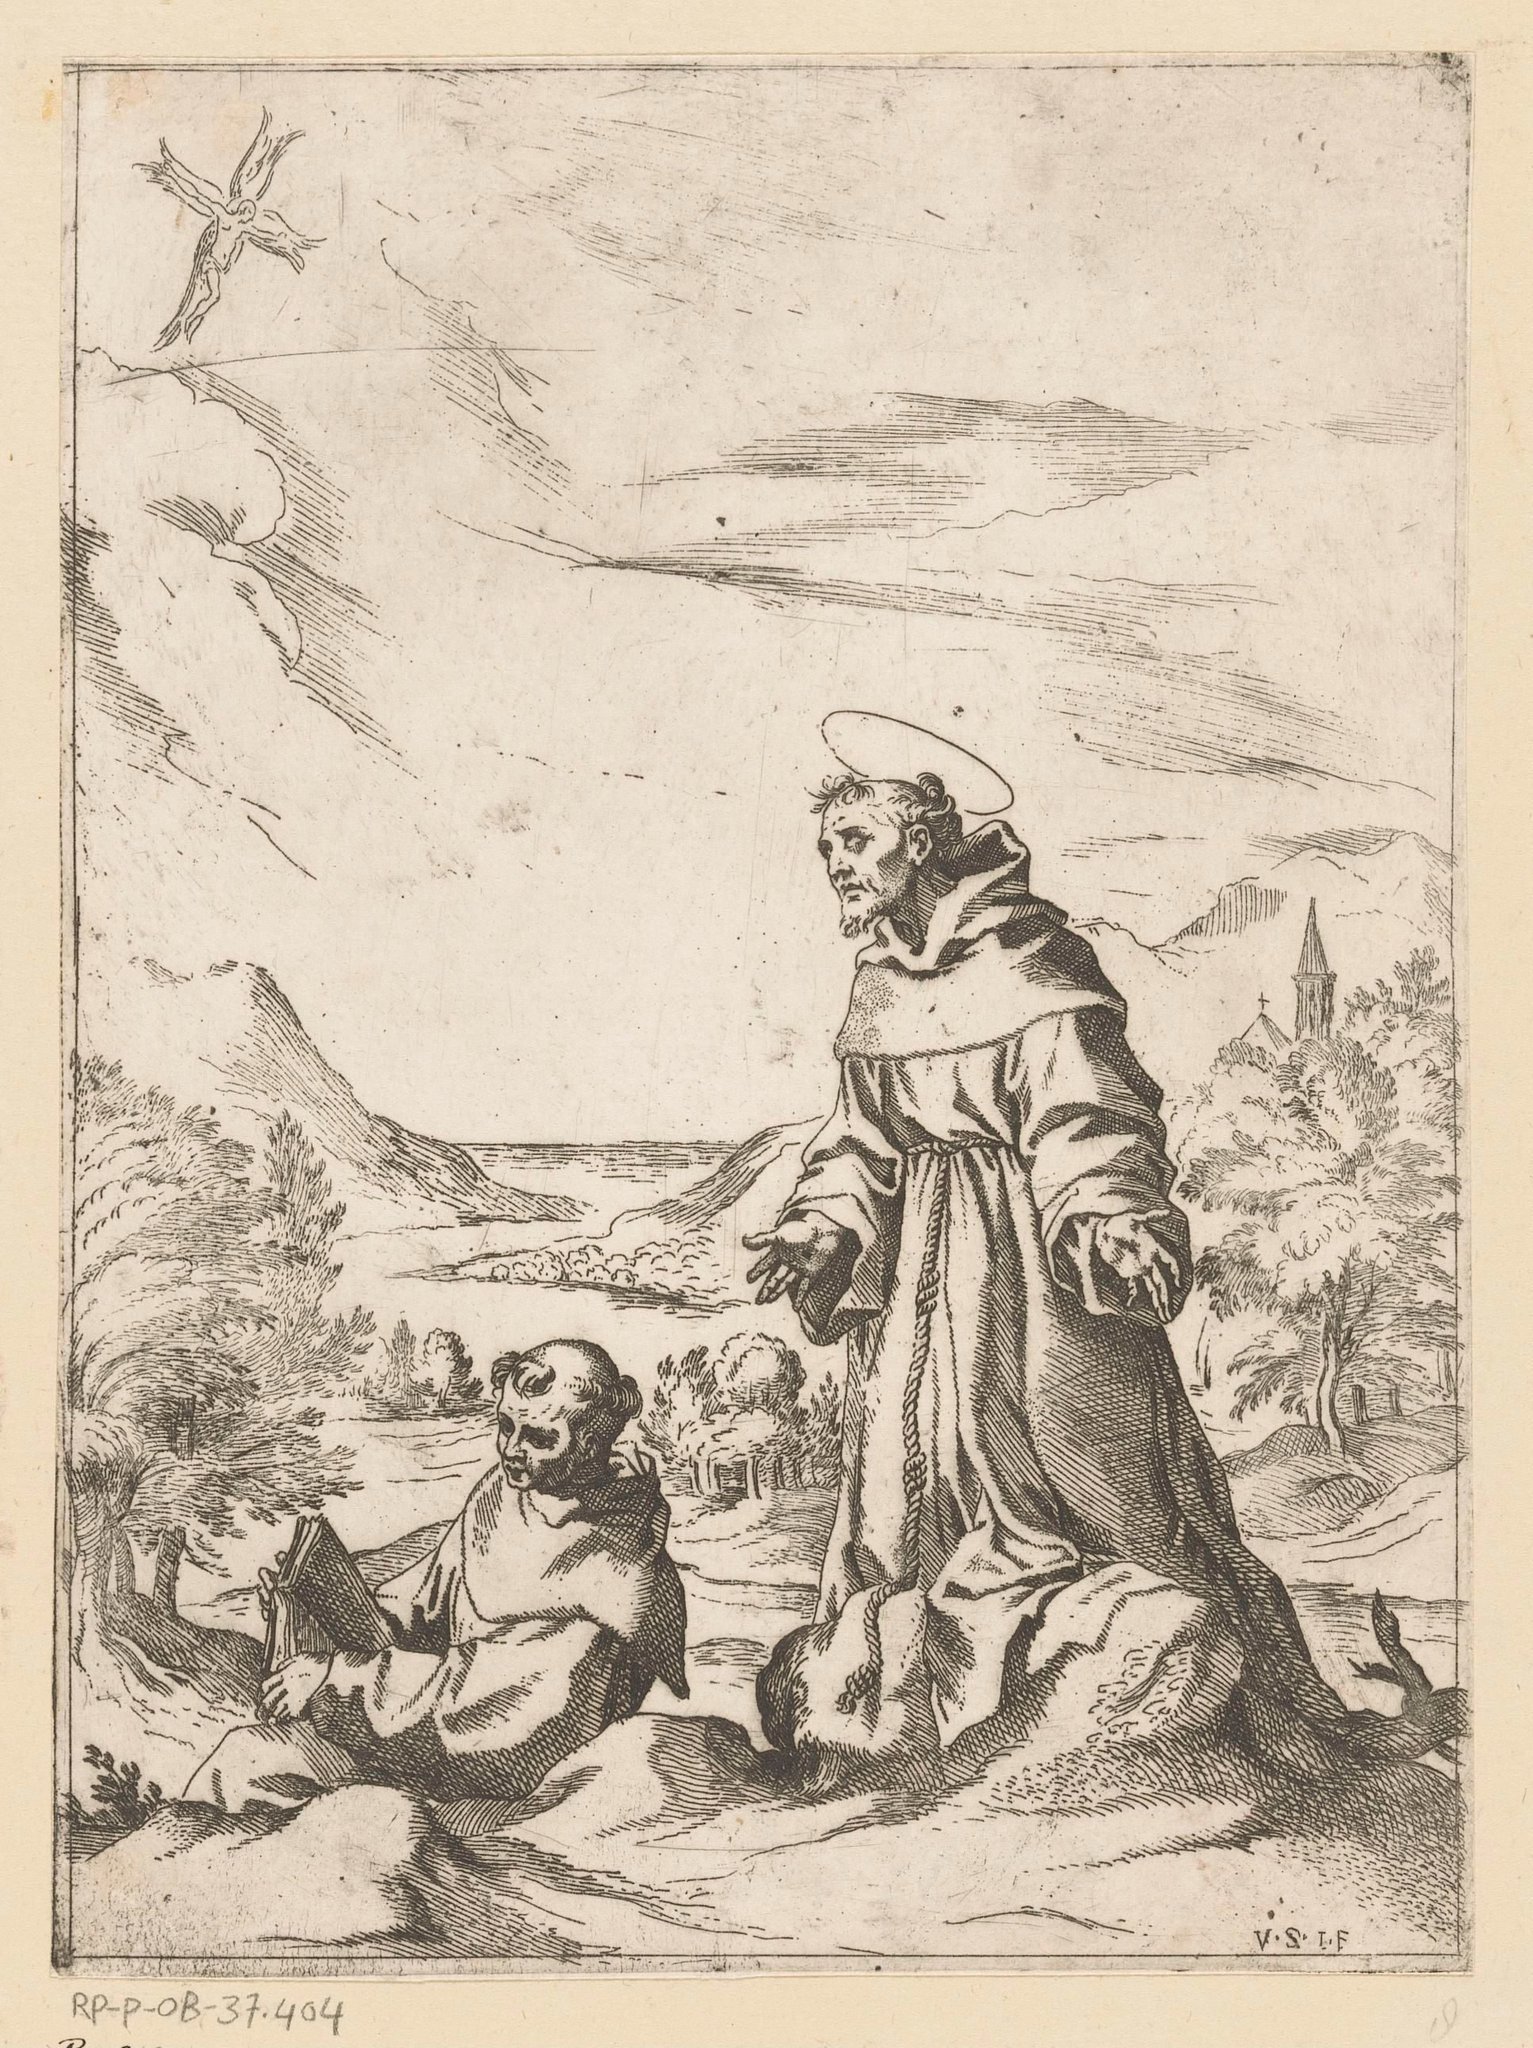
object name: print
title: Heilige Franciscus ontvangt de stigmata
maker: vespasiano strada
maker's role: draughtsman, painter, print maker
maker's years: 1582-1622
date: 1592-1622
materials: paper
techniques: etching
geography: italy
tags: stigmatization of st. francis of assisi: in retreat on mount alverna, he beholds a vision of christ on the cross enveloped by wings (like a seraph with six wings); rays passing down to the body of the kneeling saint form the marks of the five wounds of christ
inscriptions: collector's mark: Lugt 240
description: De heilige Franciscus aanschouwt zijn visioen en ontvangt de kruiswonden (stigmata). Links een Franciscaan met een boek.